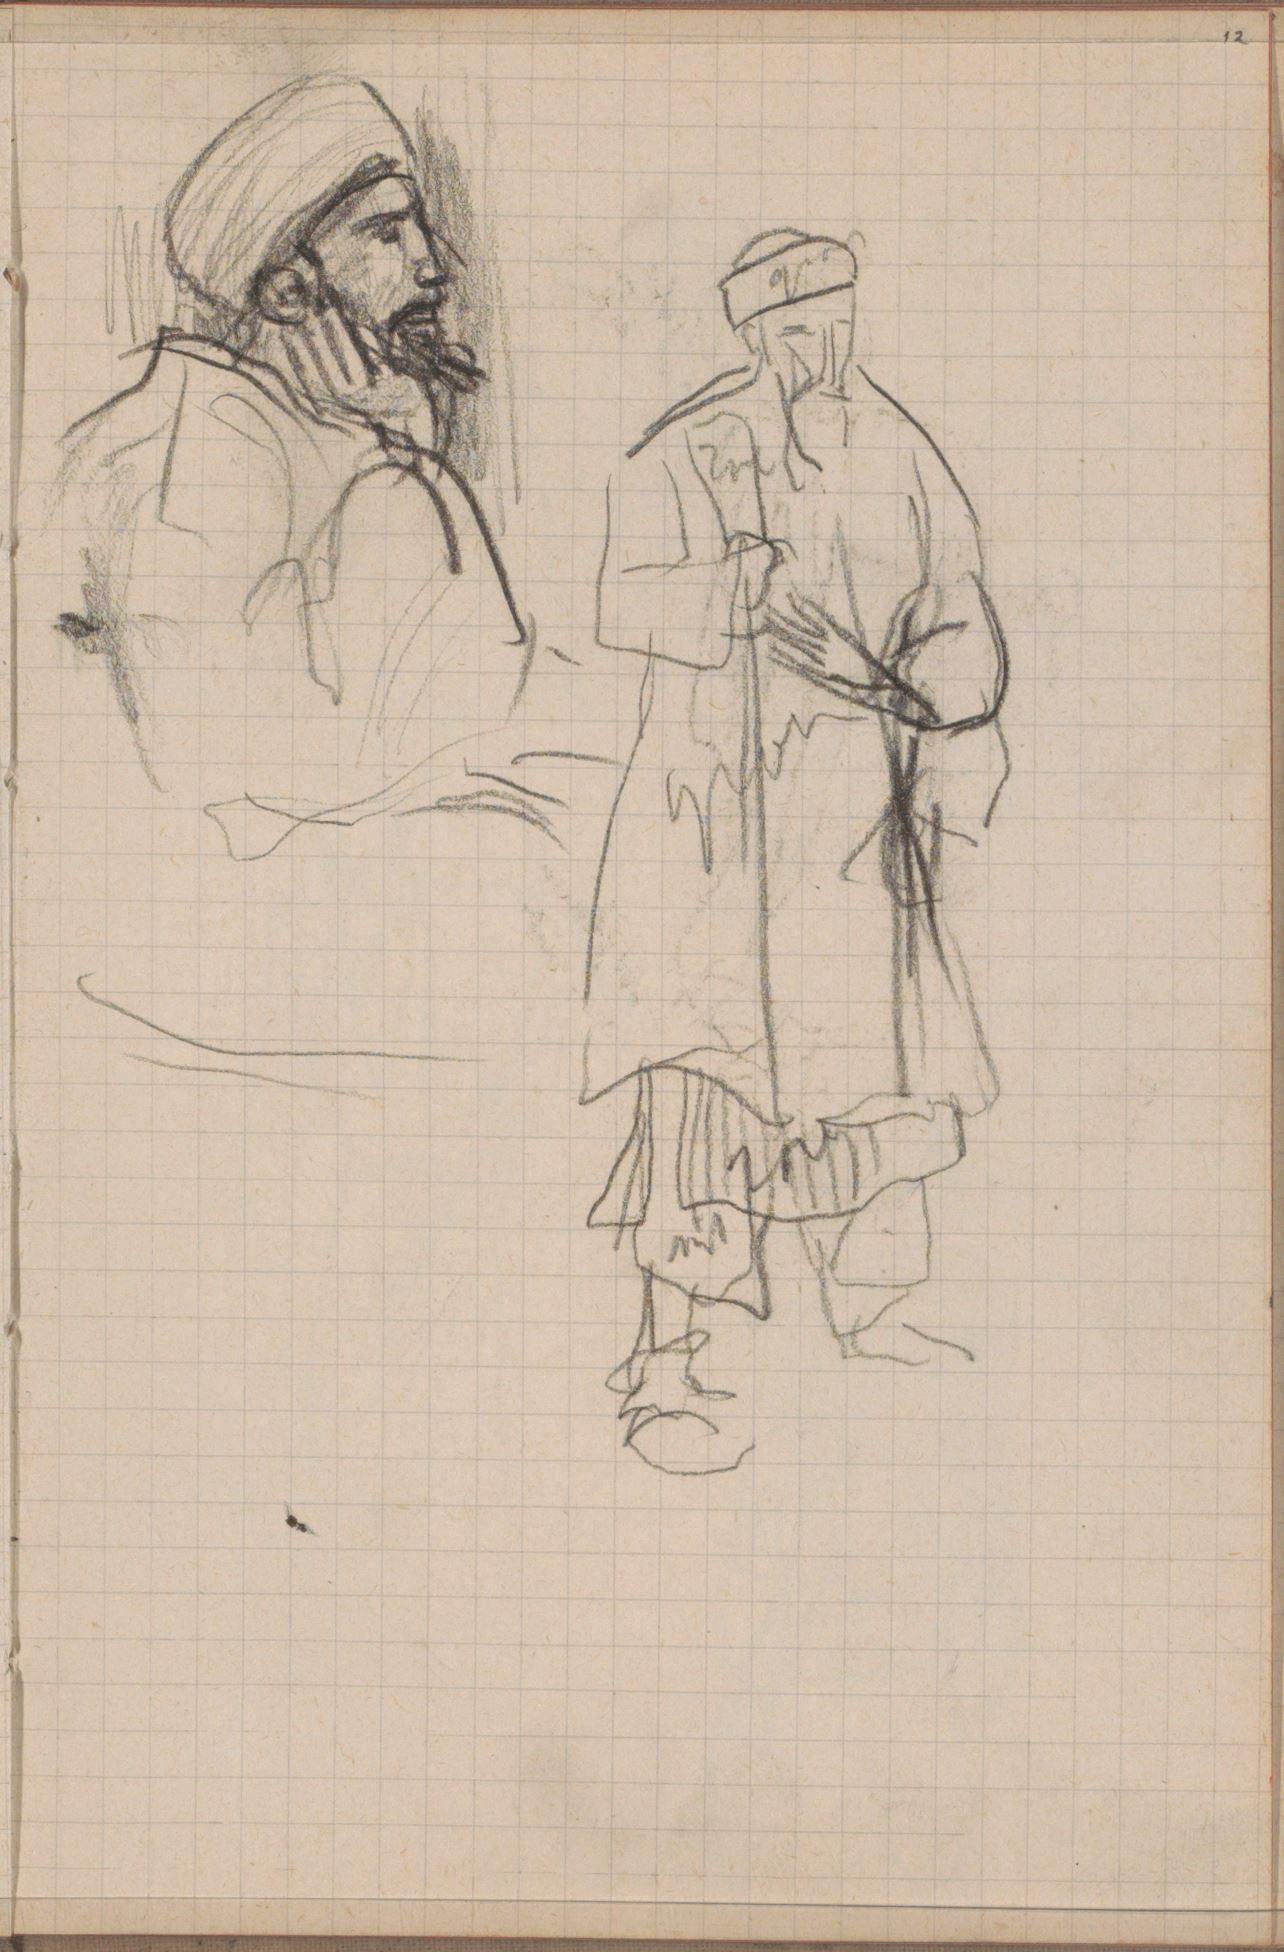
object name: sketchbook leaf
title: Twee figuren in oosterse kleding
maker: marius bauer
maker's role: draughtsman, print maker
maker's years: 1867-1932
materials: chalk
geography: istanbul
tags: asiatic races and peoples, head (human), standing figure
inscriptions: kleurnotitie, handgeschreven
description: Vooraanzicht van een staande figuur en een zijaanzicht van een man met baard en tulband, zijn hoofd rustend in zijn hand. Pagina 12 uit een schetsboek met 51 bladen.